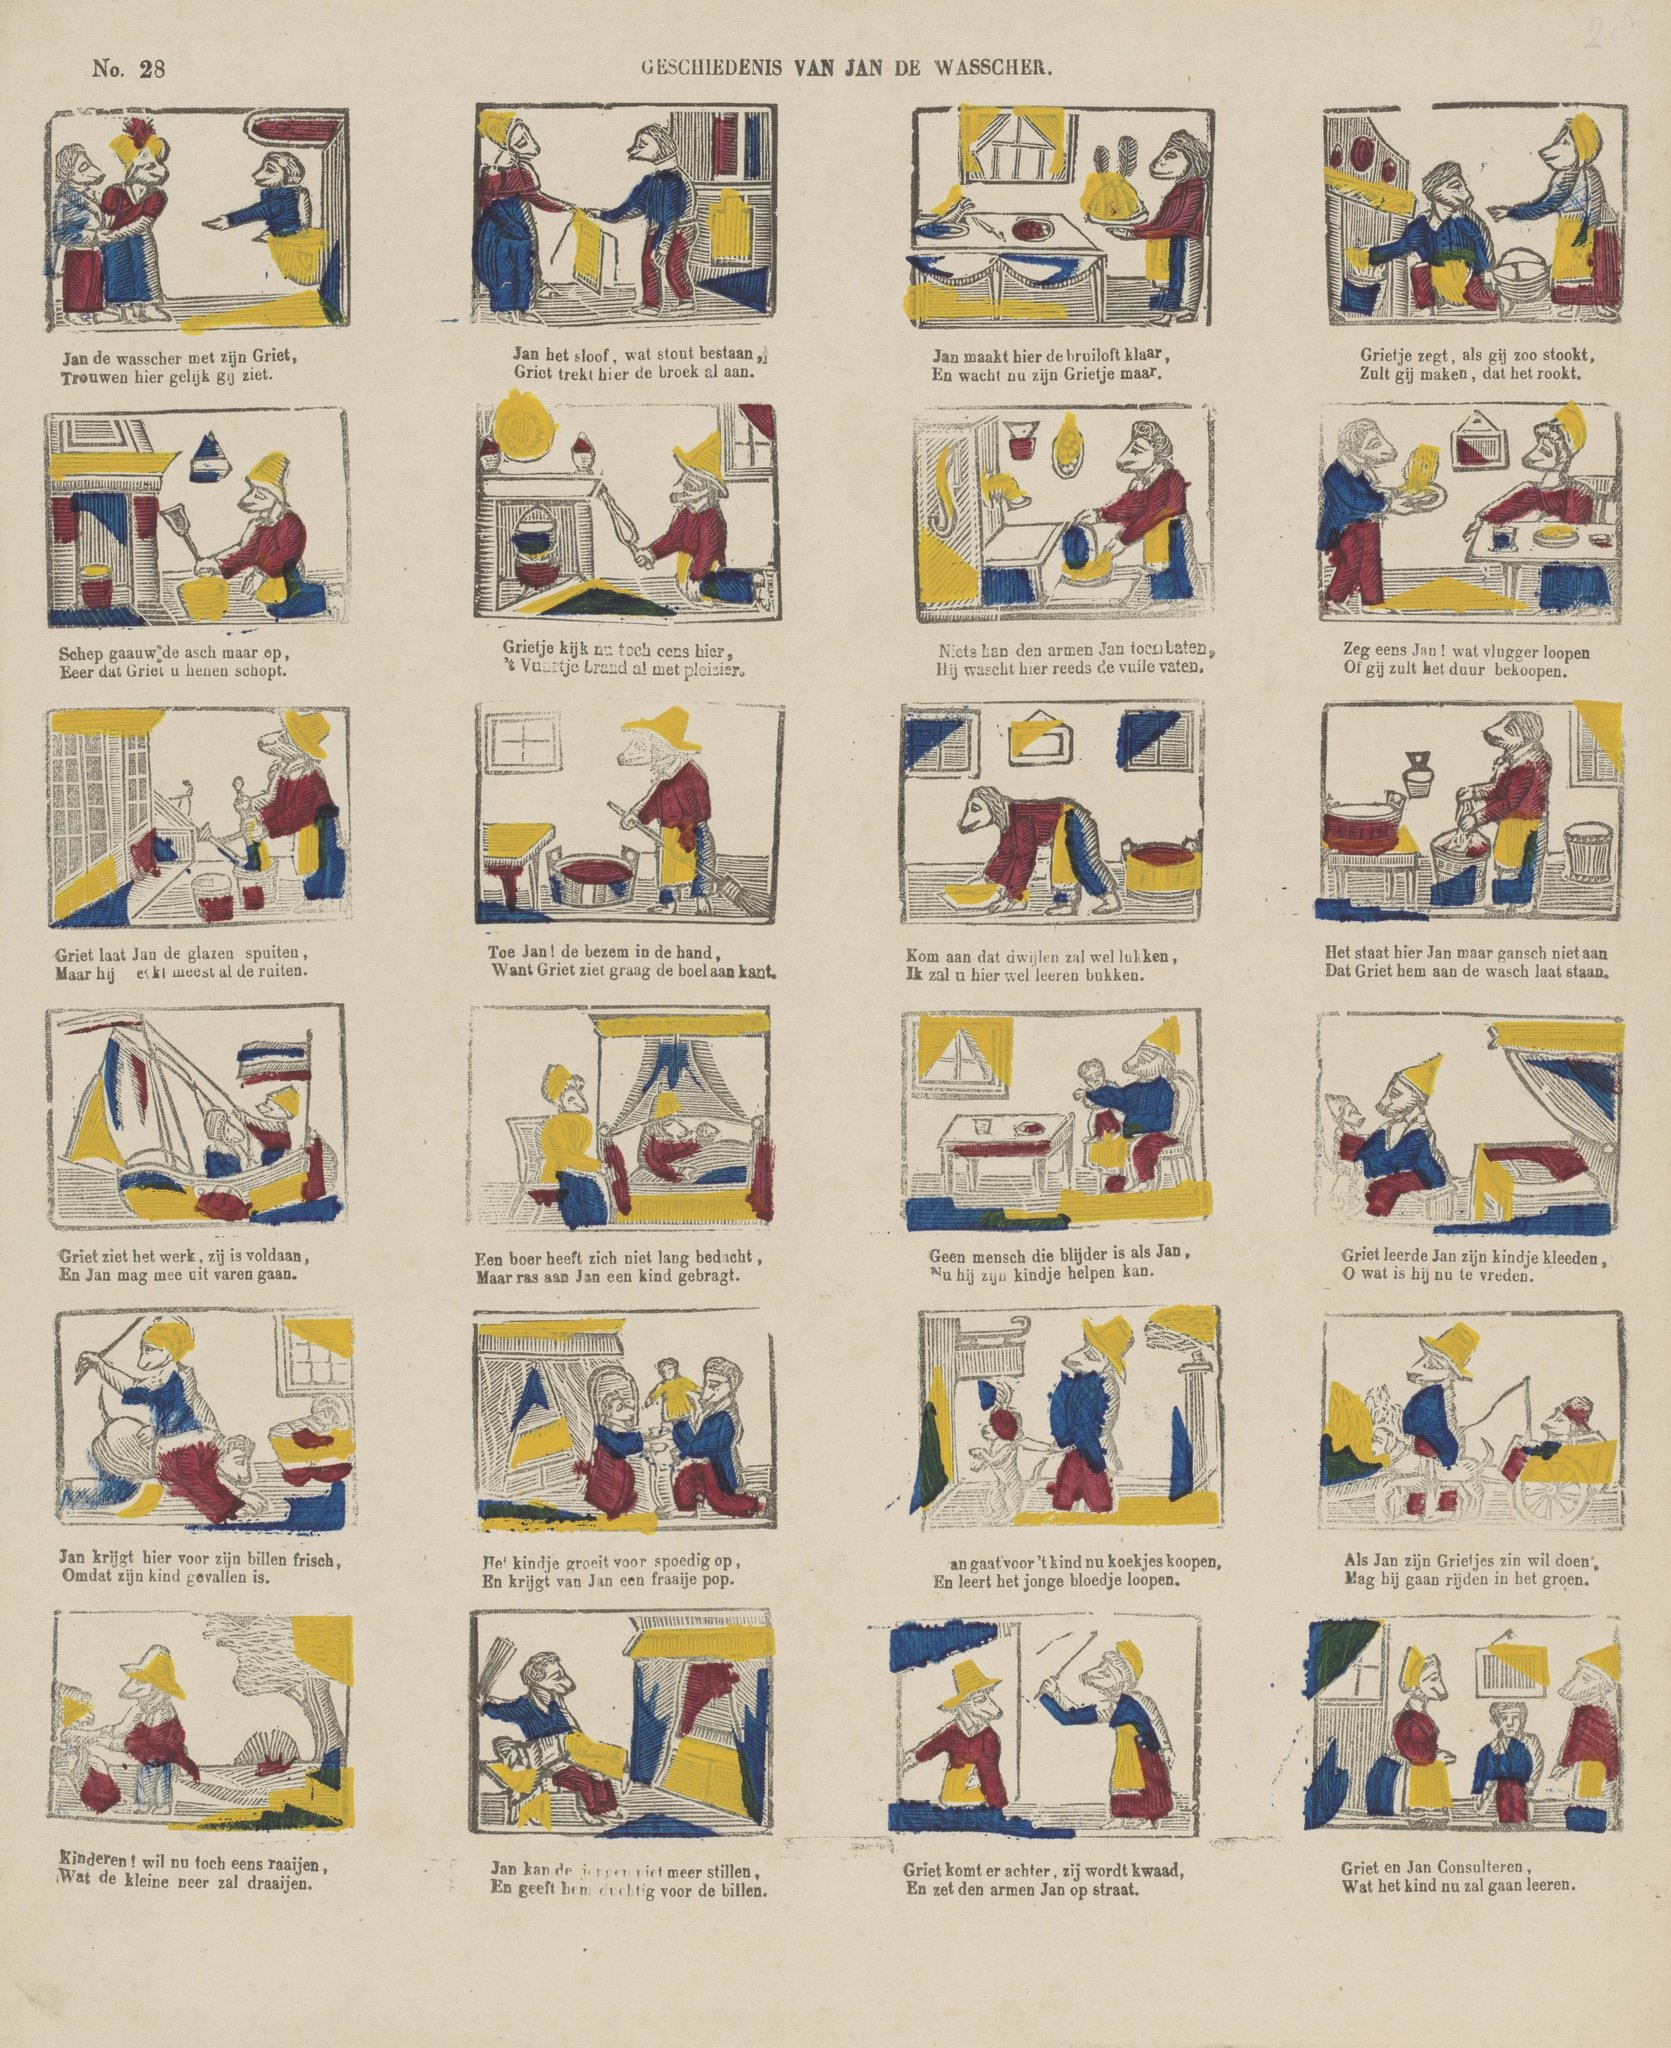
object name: print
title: Geschiedenis van Jan de Wasscher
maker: Anonymous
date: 1848-1881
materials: paper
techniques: colour, letterpress printing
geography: netherlands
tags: hen-pecked husband, 'betty', 'molly' (man who engages in women's work), monkeys, apes, animals acting as human beings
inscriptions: collector's mark: Lugt 2760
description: Blad met 24 voorstellingen uit het leven van Jan de Wasser, een man die van zijn vrouw Griet, die de broek aan heeft, al het huishoudelijk werk moet doen. Uitgebeeld met apen in plaats van mensen. Onder elke voorstelling een tweeregelig vers. Genummerd linksboven: No. 28.